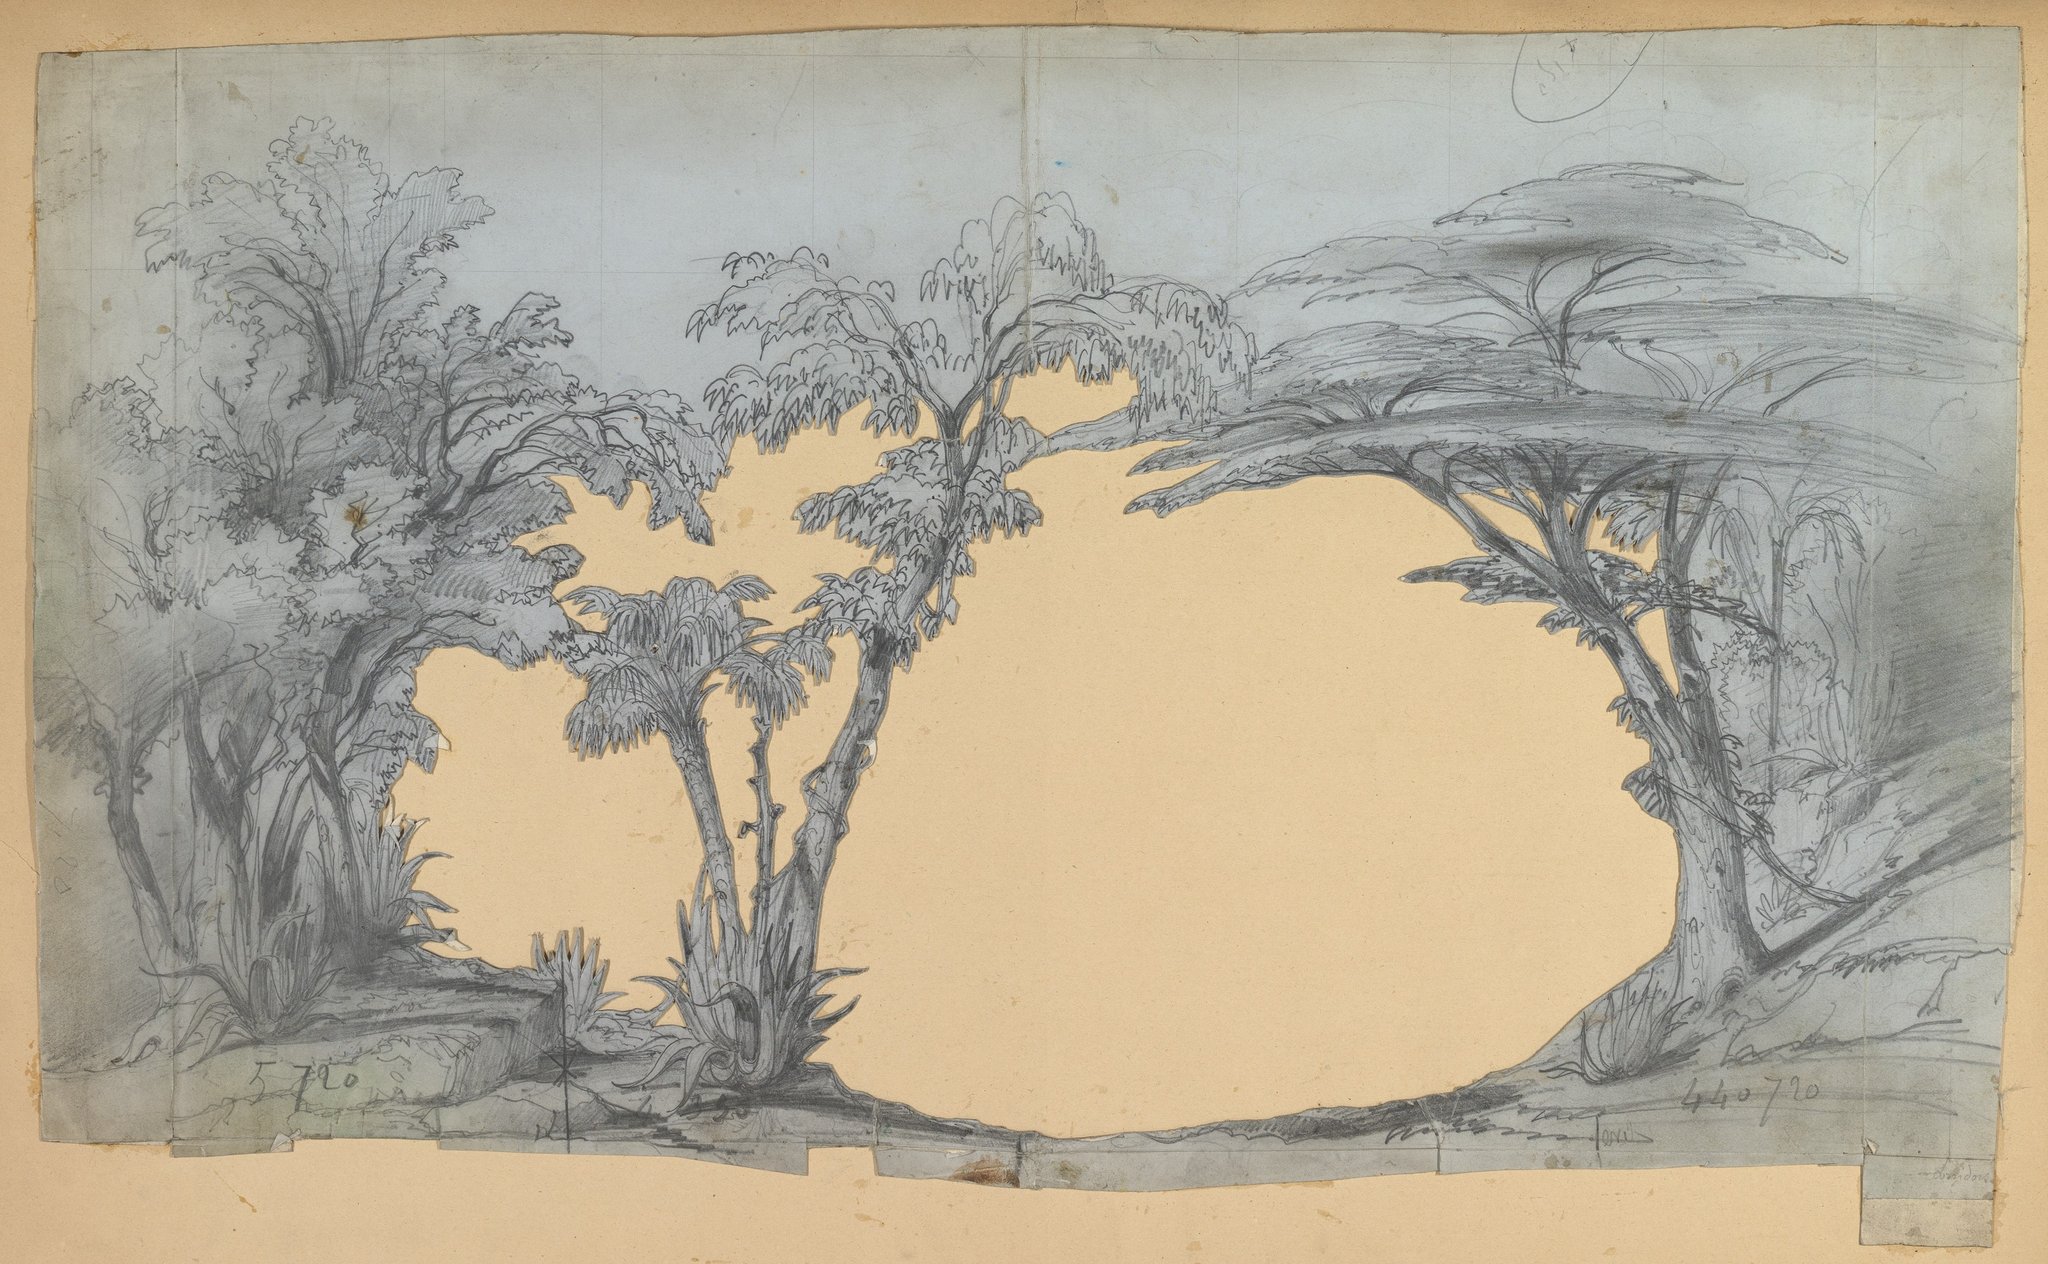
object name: drawing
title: Design for a Stage Set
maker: eugène cicéri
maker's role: artist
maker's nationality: french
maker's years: 1813-1890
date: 1830-1890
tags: trees,stage design